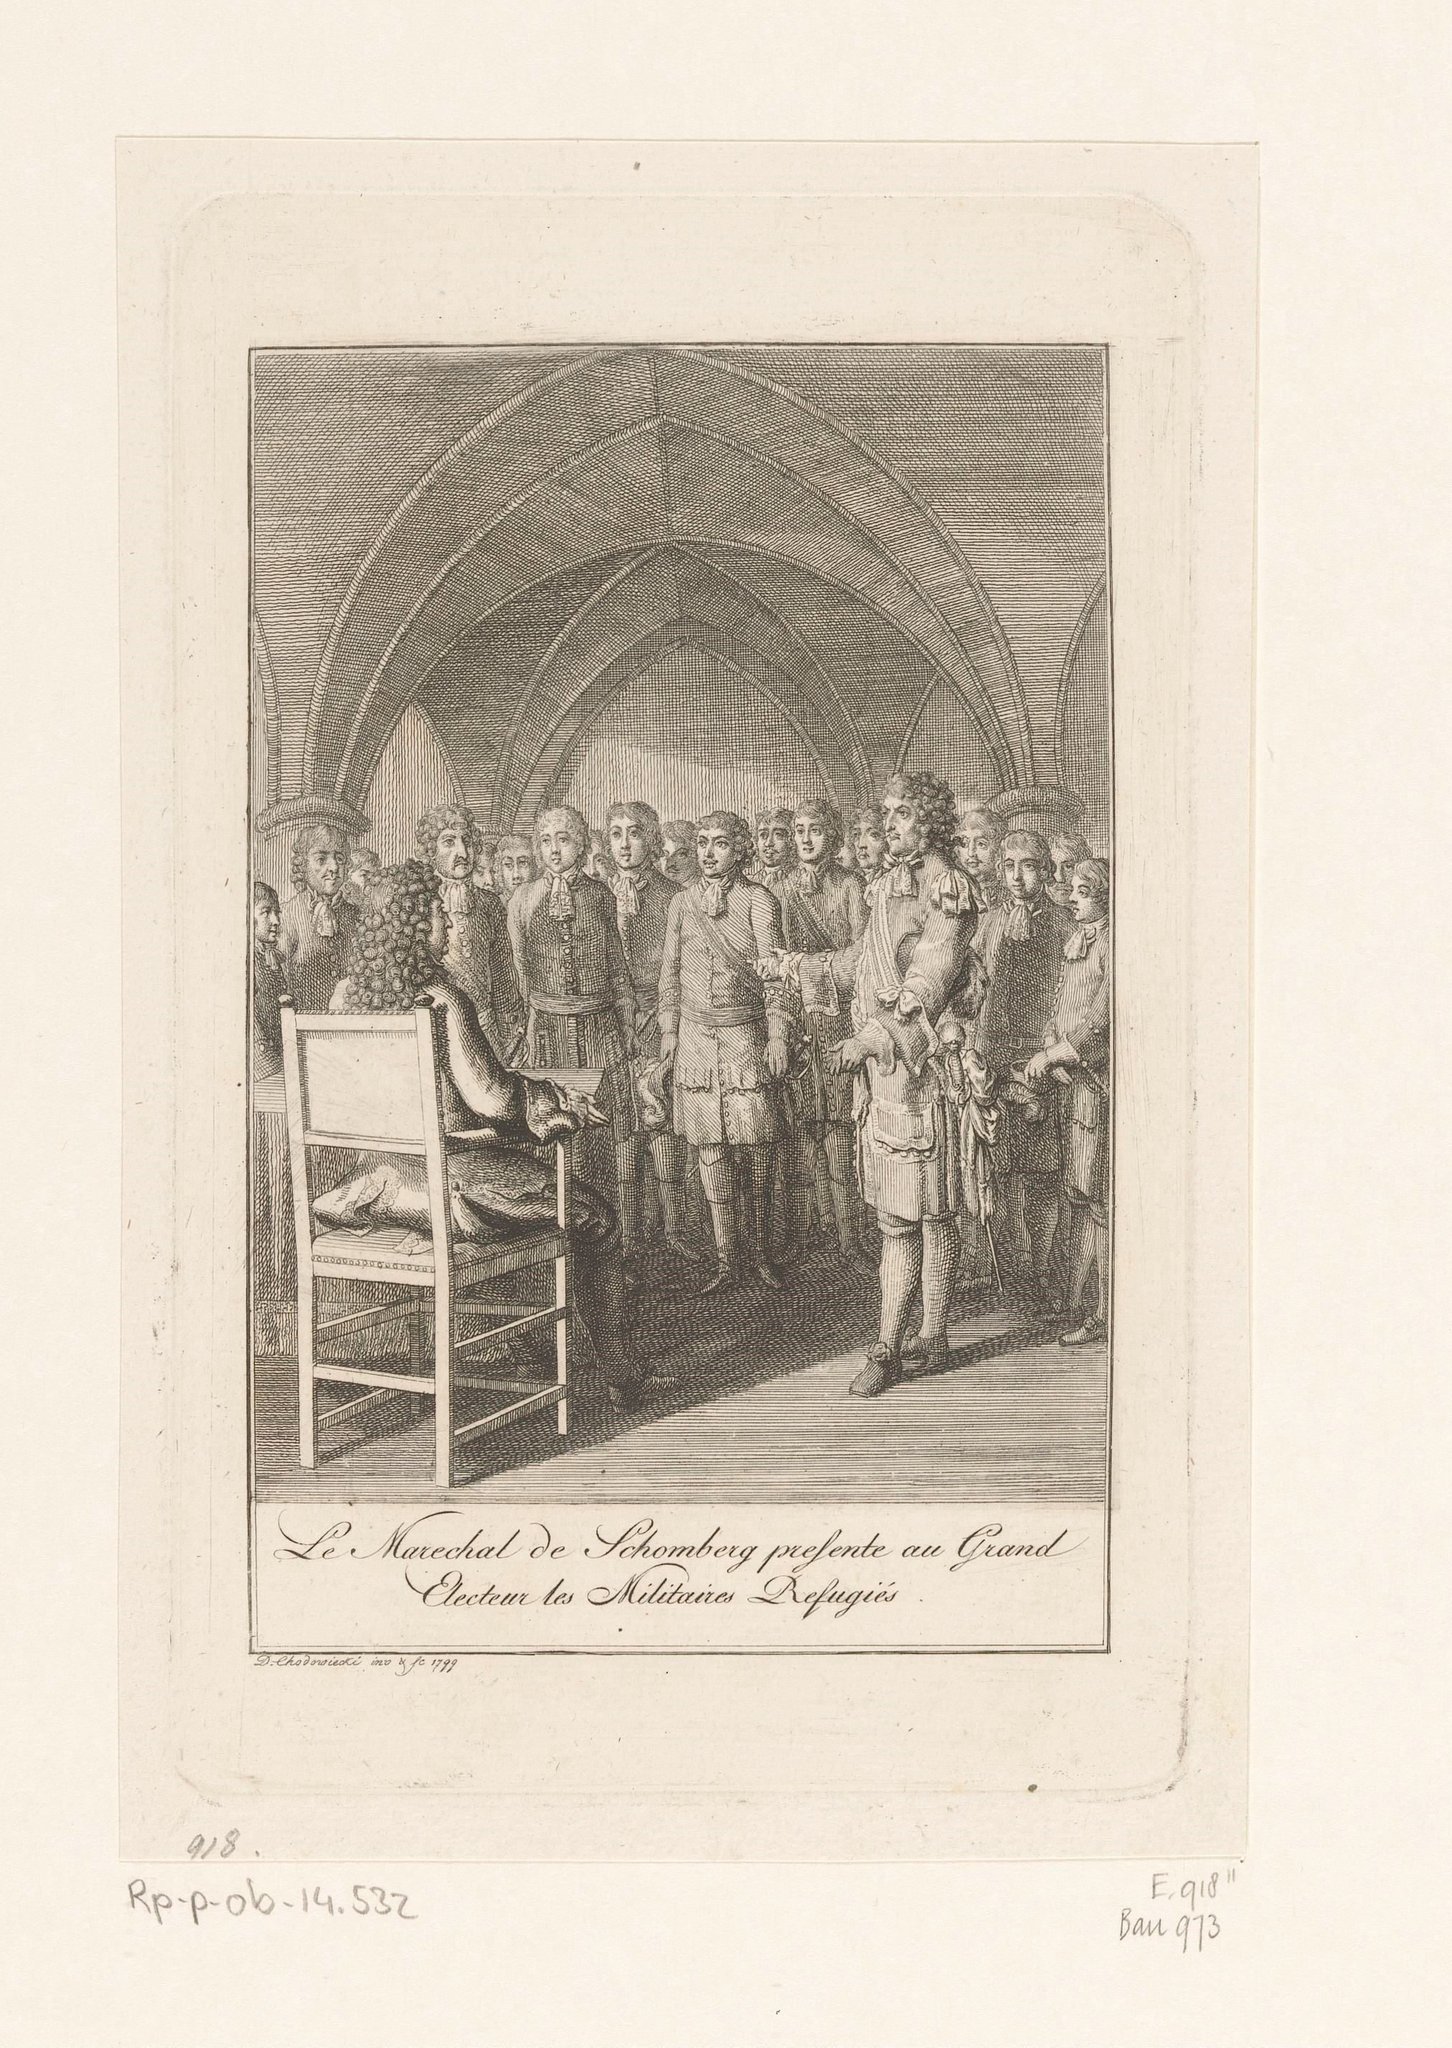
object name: print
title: Friedrich I wordt voorgesteld door de hertog van Schomberg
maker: daniel nikolaus chodowiecki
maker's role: draughtsman, print maker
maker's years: 1726-1801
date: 1799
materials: paper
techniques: etching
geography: berlin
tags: berlin, friedrich i (koning van pruisen), introducing, commander-in-chief, general, marshal, ruler, sovereign, vault ~ architecture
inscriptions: collector's mark: Lugt 2228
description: Prent gebruikt voor: Erman, Jean Pierre. Mémoires pour servir à l'histoire des réfugiés françois dans les états du roi. 9 dln. Berlijn: Fred. Barbiez, 1799, dl. 9.